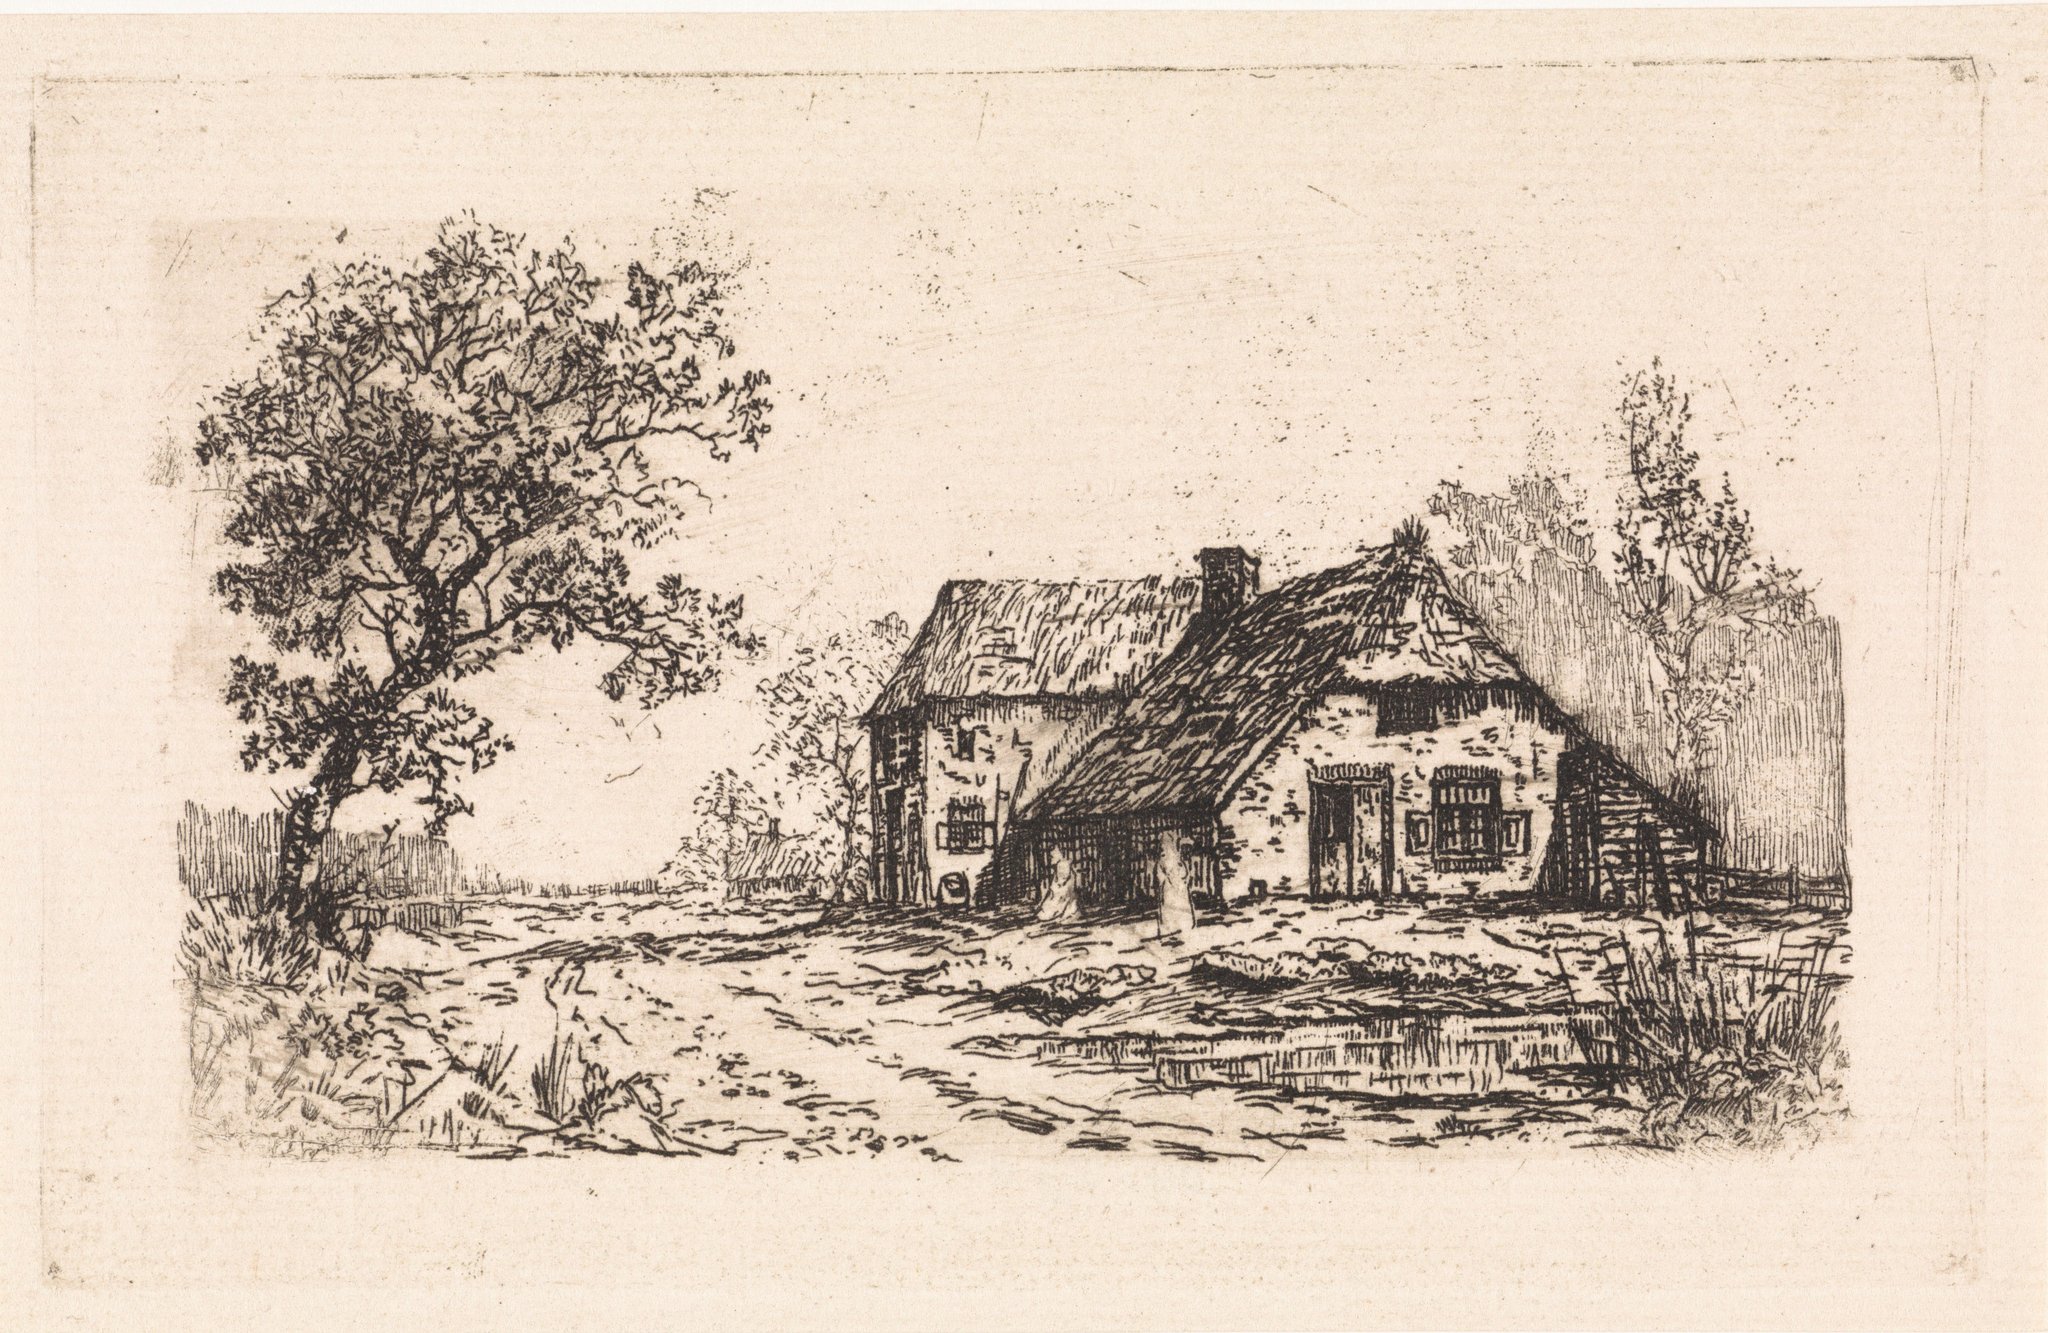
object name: print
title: Boerderij in een landschap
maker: elias stark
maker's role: draughtsman, print maker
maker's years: 1849-1933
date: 1859-1933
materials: paper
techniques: etching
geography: netherlands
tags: farm or solitary house in landscape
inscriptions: collector's mark: Lugt 2228